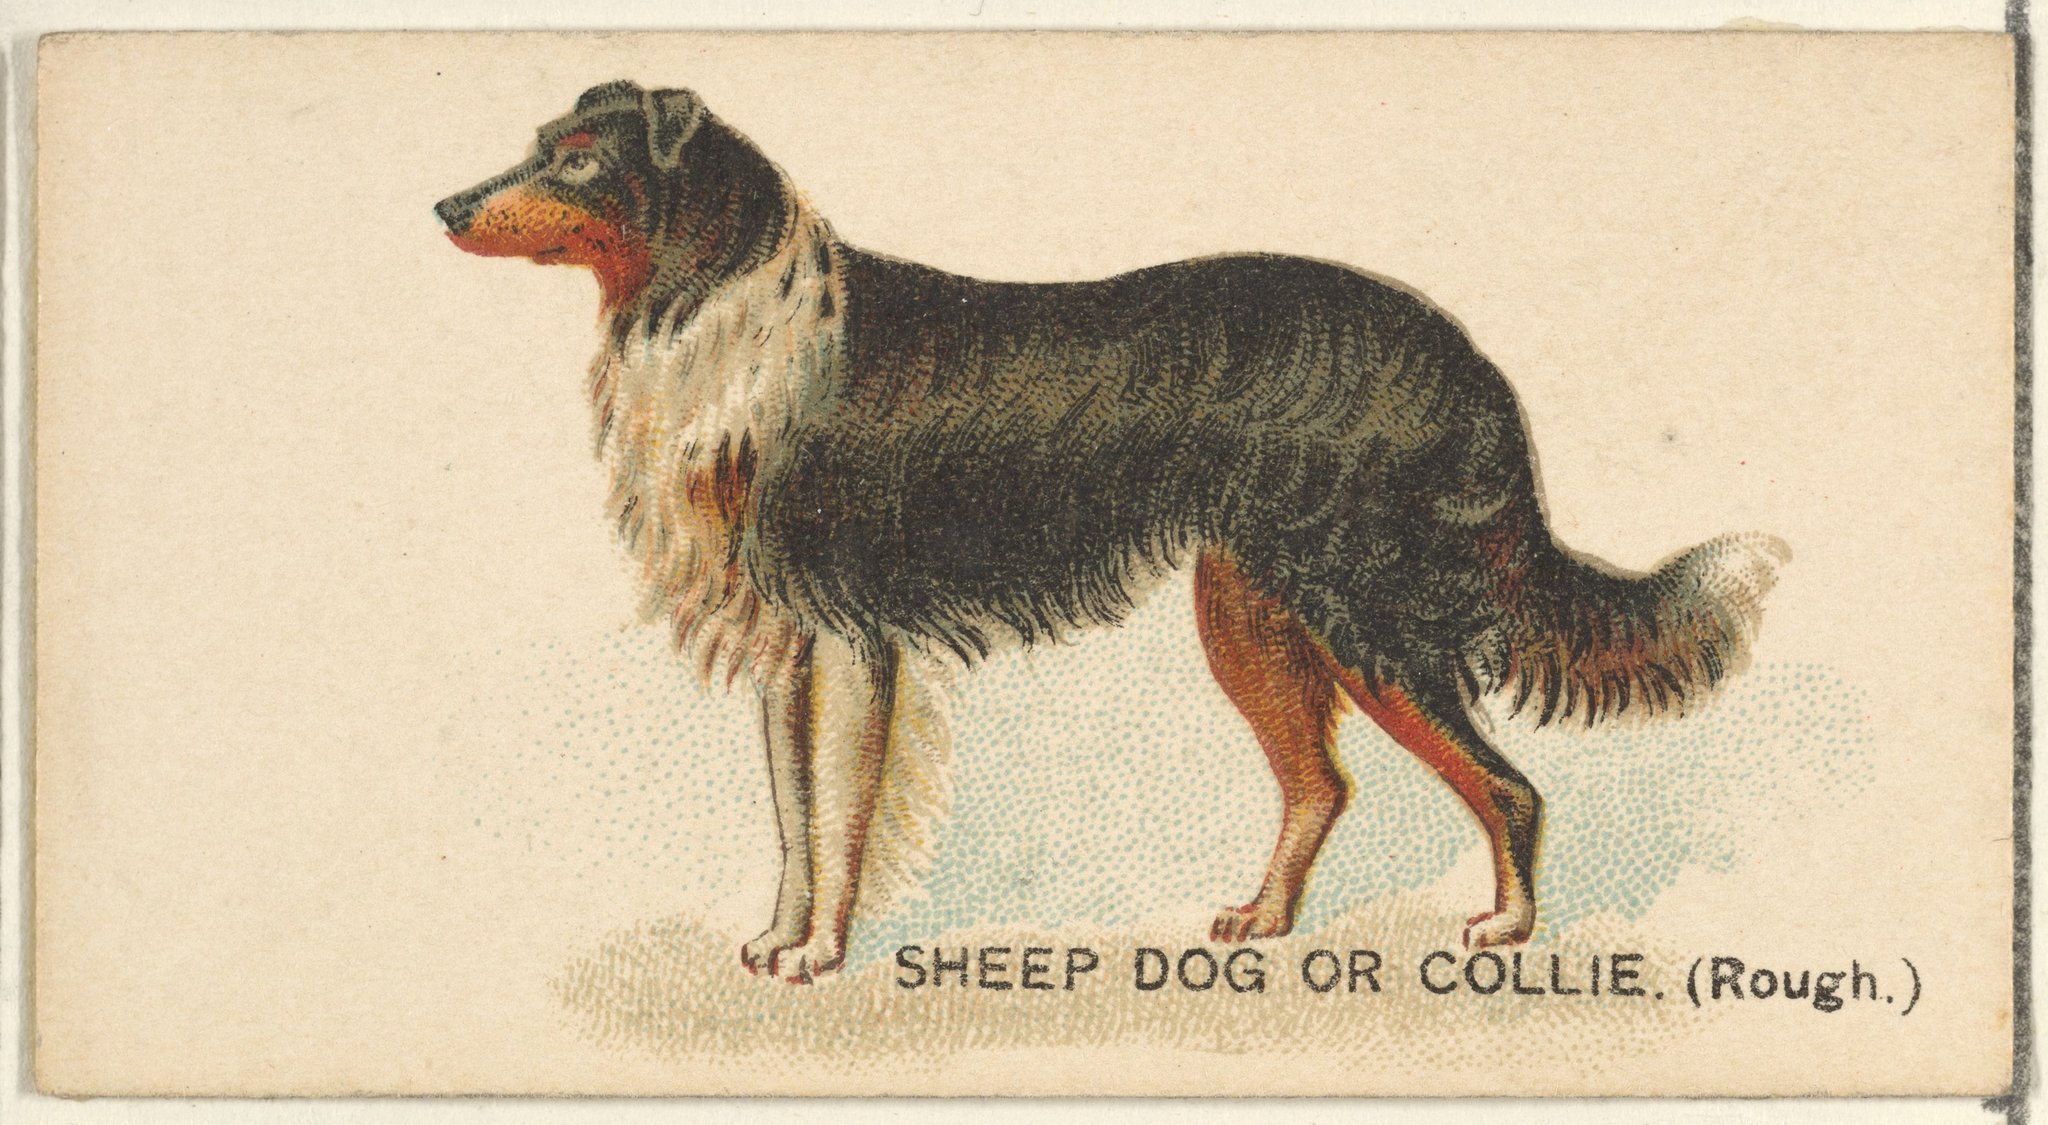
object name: print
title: Sheep Dog or Collie (Rough), from the Dogs of the World series for Old Judge Cigarettes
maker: goodwin & company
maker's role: publisher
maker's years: 1850-1950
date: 1890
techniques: color lithograph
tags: dogs